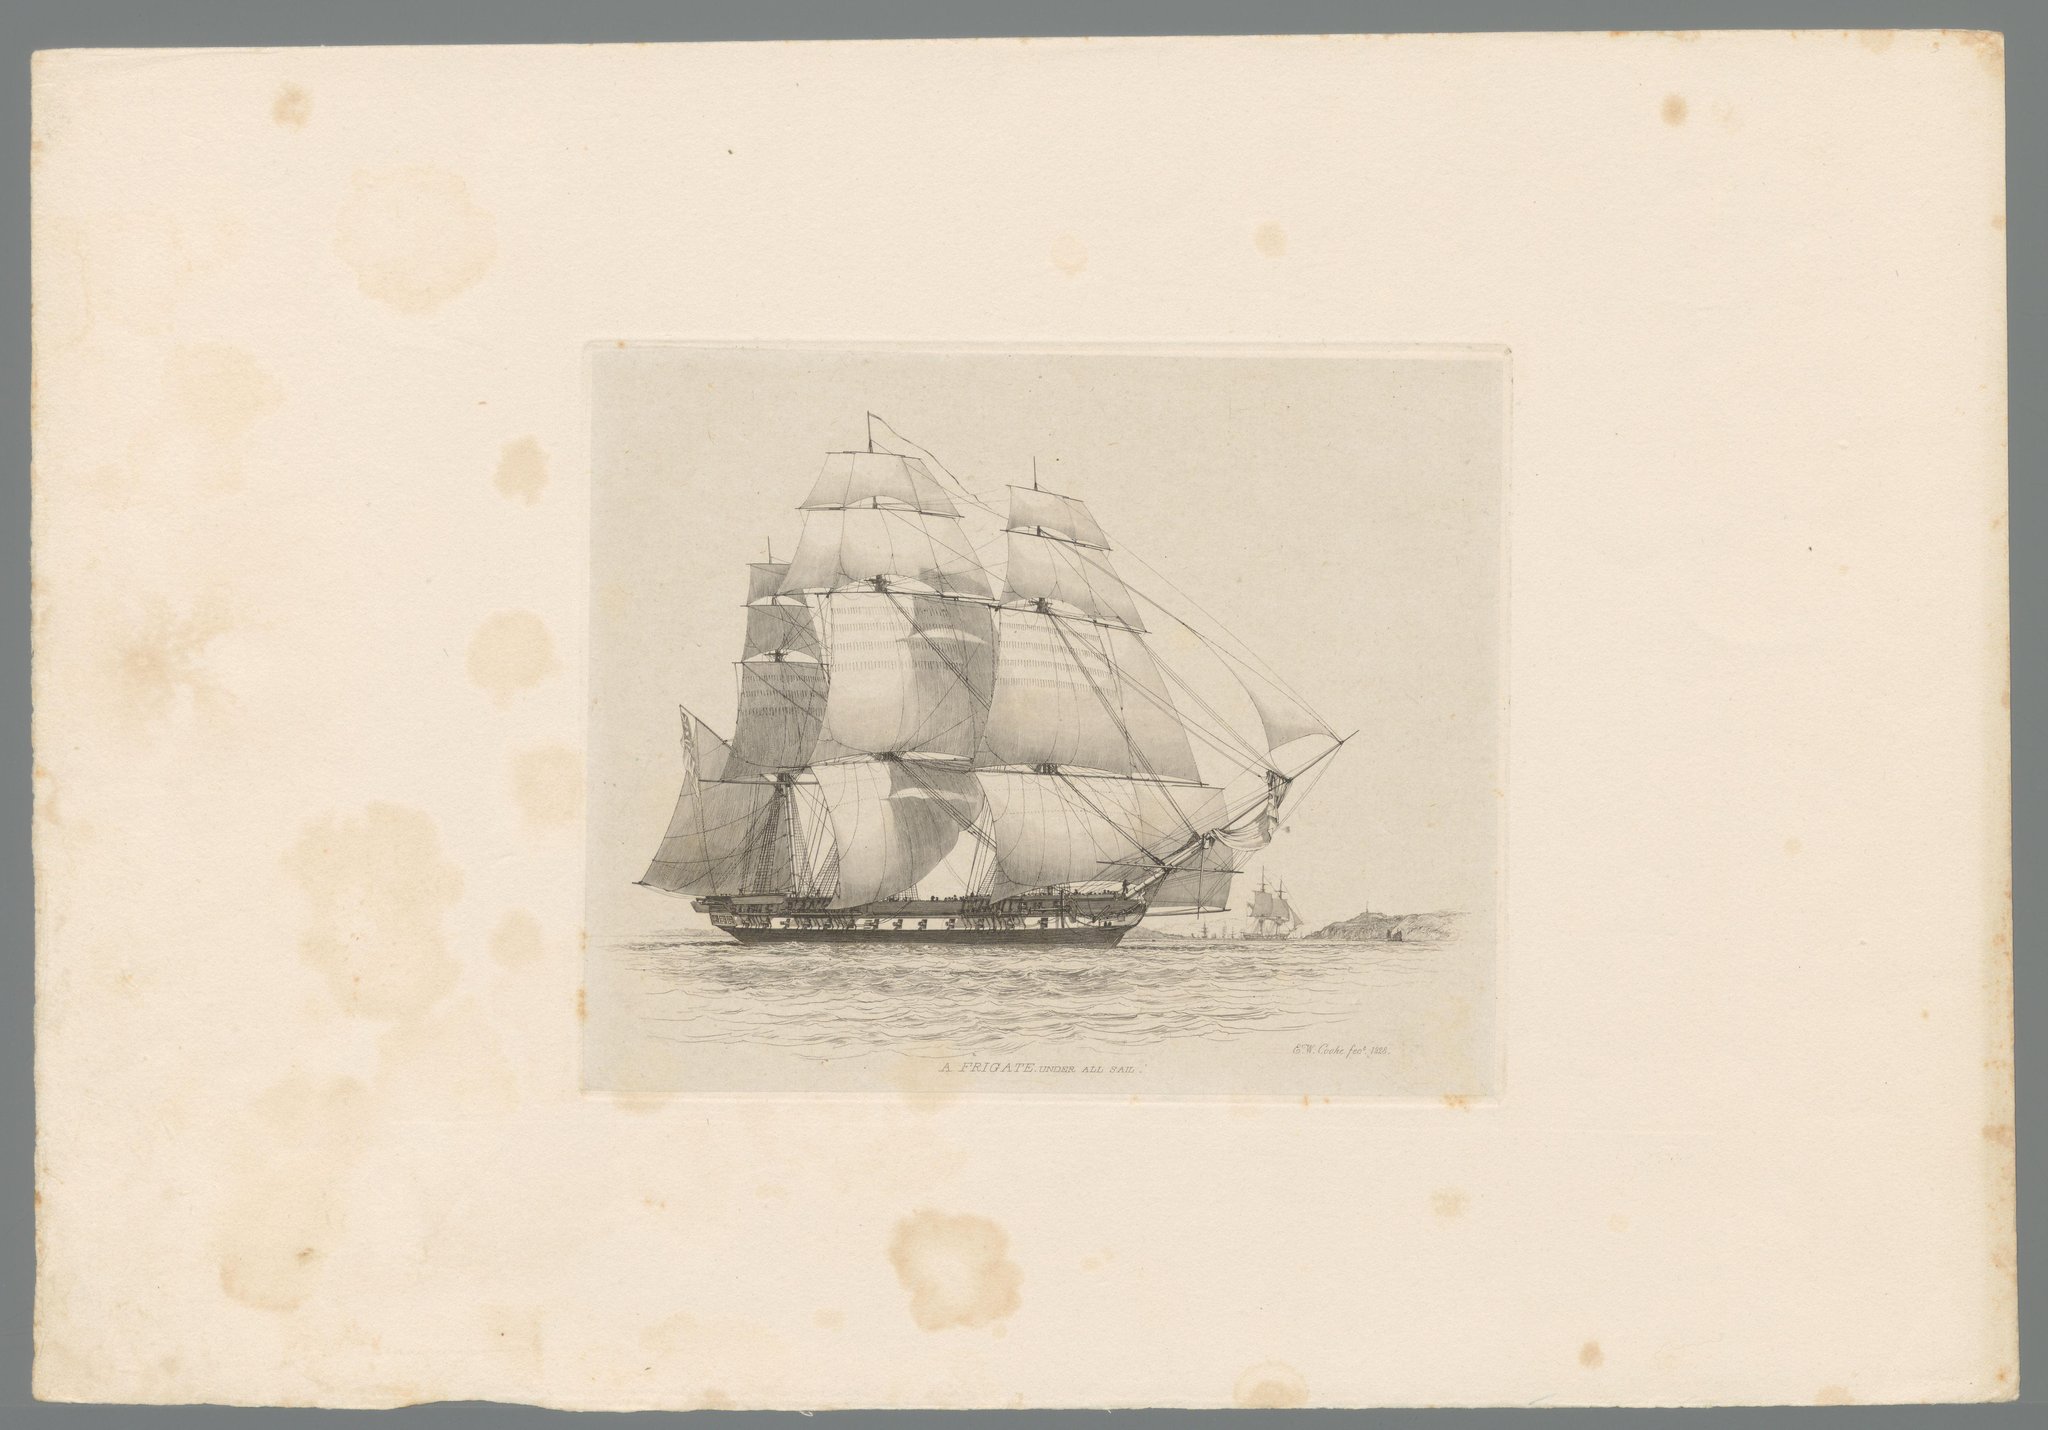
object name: print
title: A Frigate under all sail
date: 1828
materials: paper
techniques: etching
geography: london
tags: sailing-ship, sailing-boat, coast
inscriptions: collector's mark: Lugt 2165